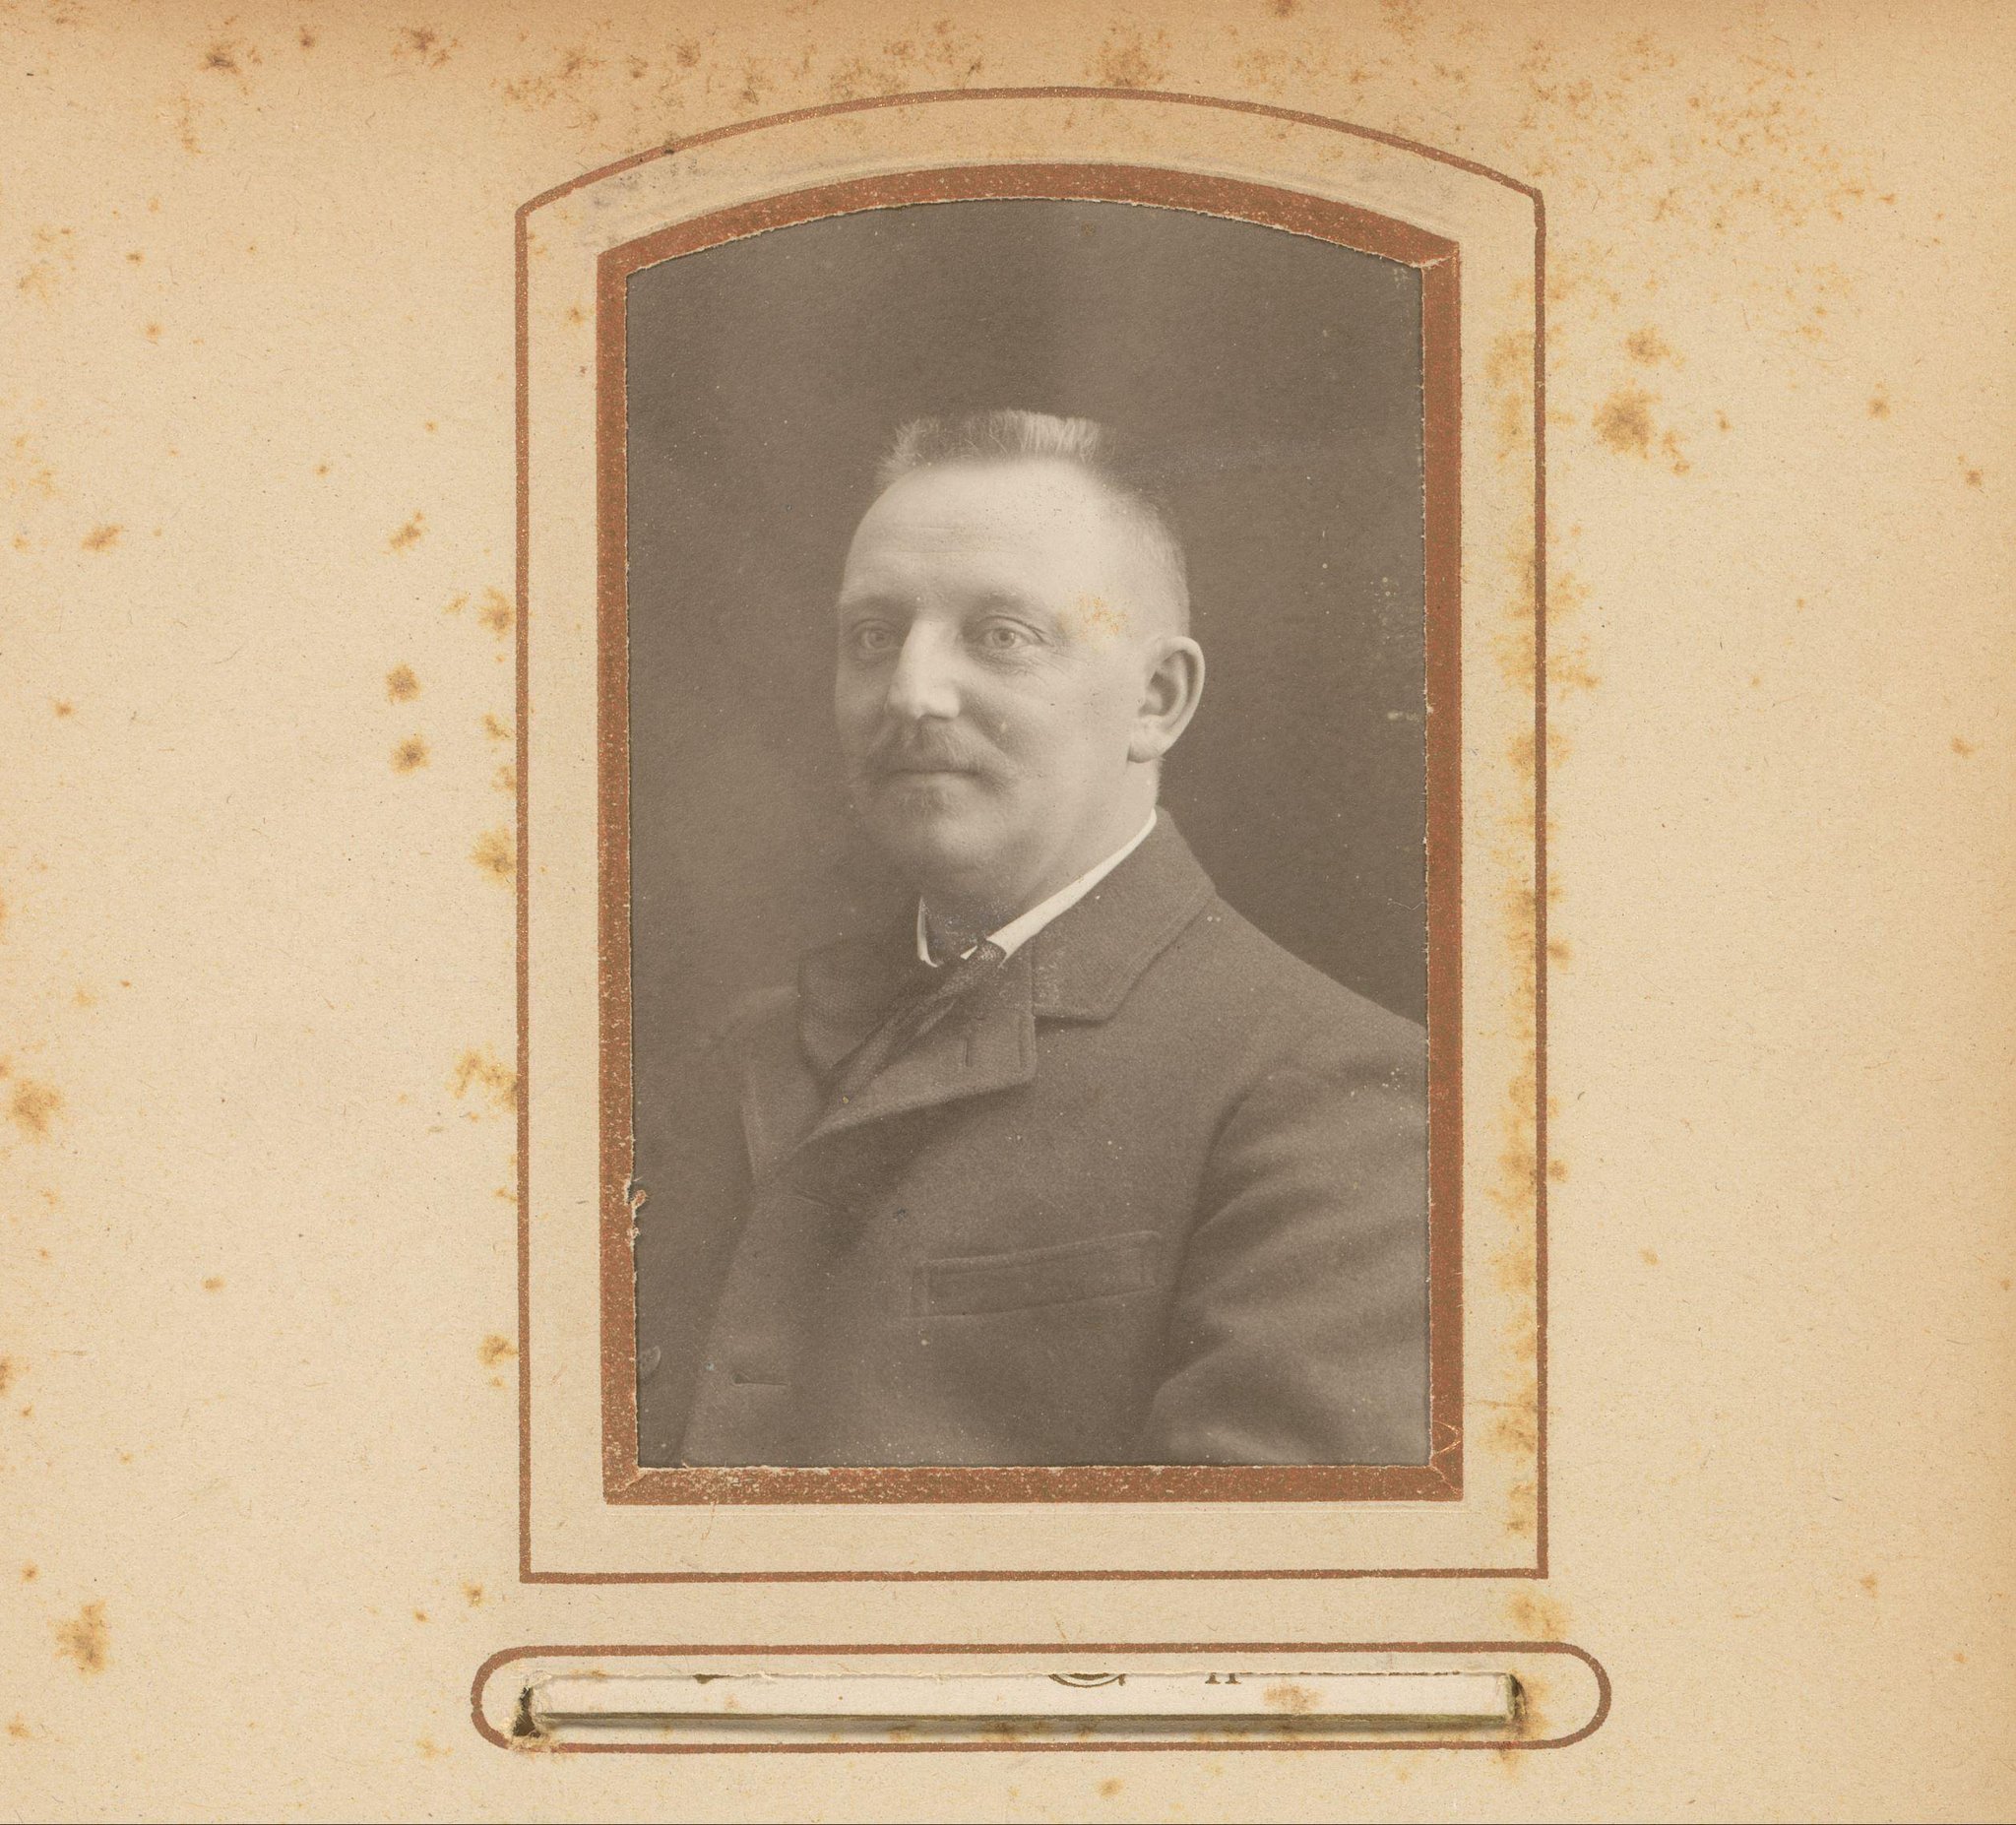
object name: photograph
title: Portret van een man met snor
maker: Anonymous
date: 1880-1910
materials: cardboard, photographic support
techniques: collodion silver print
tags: moustache, historical persons